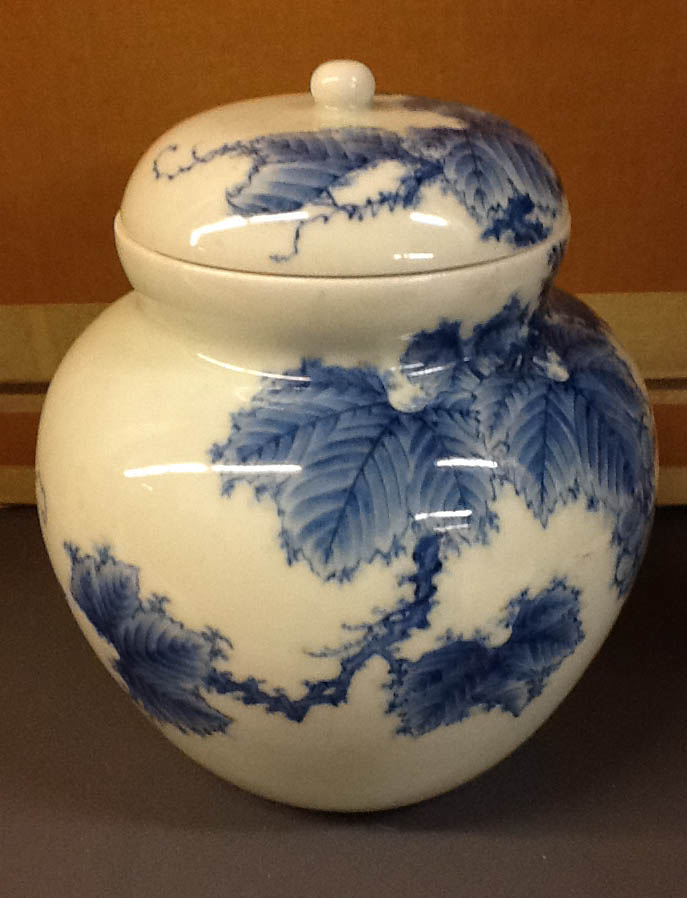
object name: jar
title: Covered Jar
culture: japanese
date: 1820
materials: glaze, porcelain